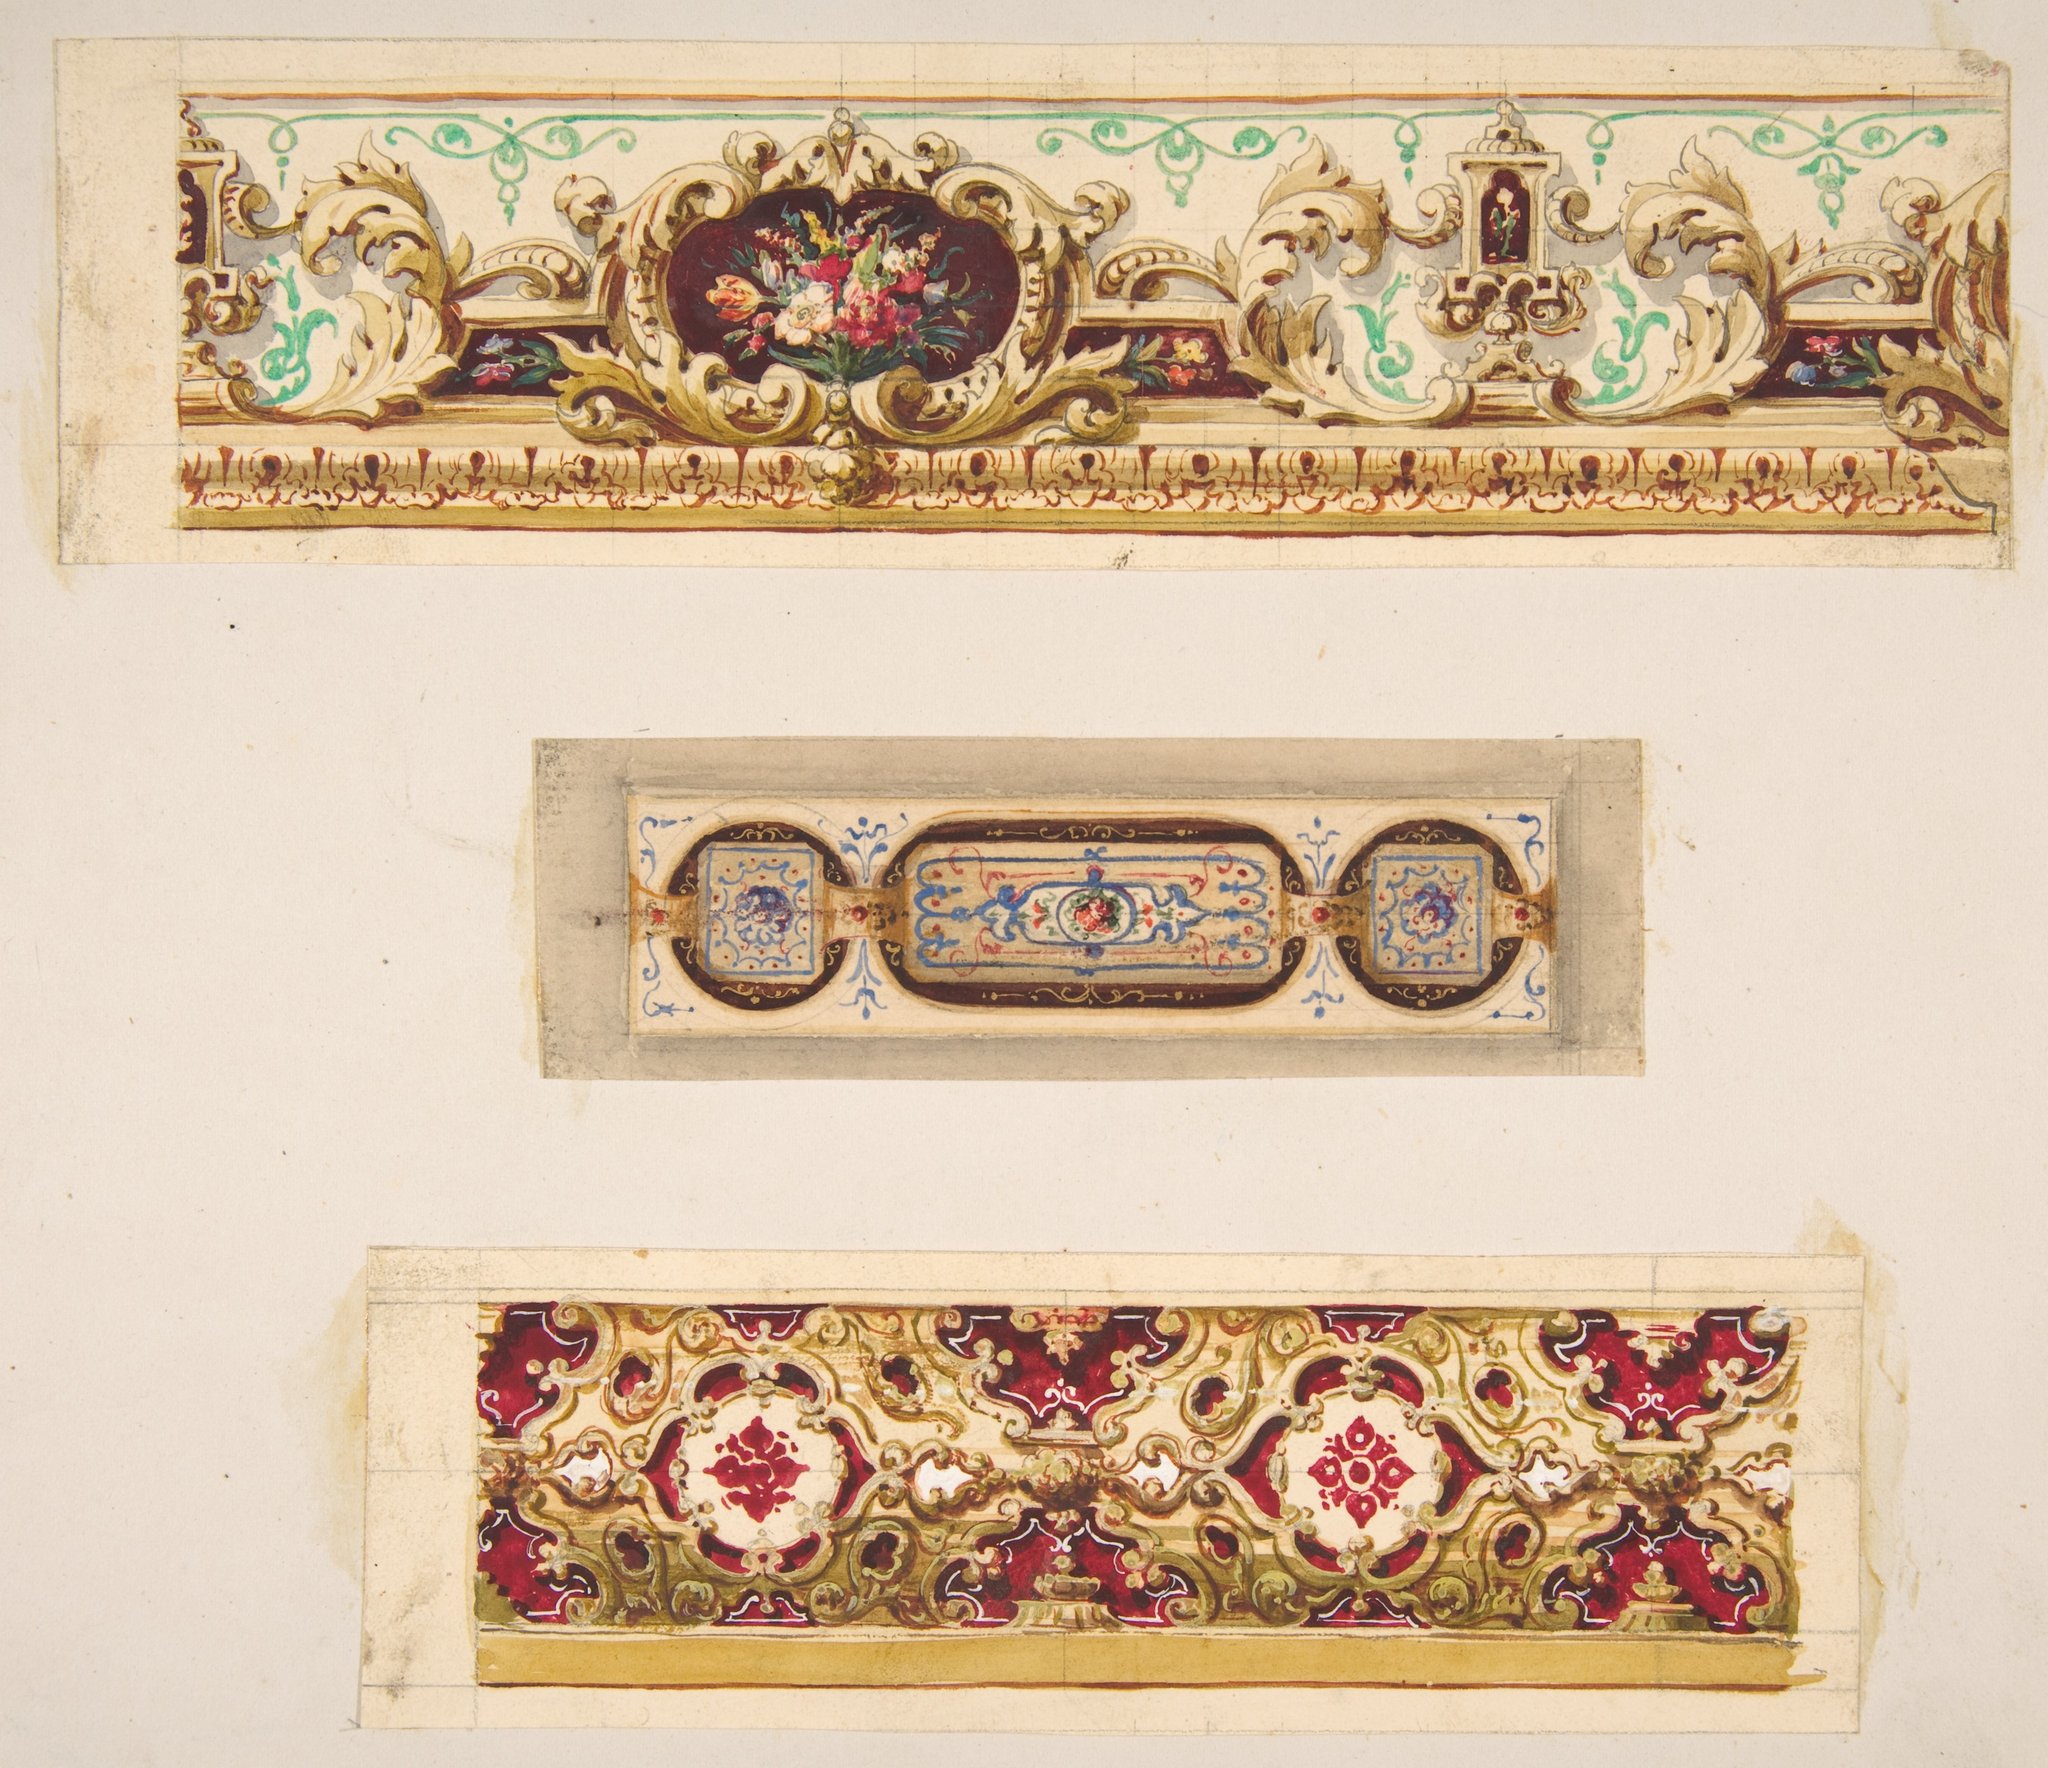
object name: drawing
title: Three designs for painted borders to decorate a room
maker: jules-edmond-charles lachaise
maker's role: artist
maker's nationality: french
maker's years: 1897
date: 1801-1900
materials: graphite, ink, watercolor, paper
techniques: pen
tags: ornament,flowers